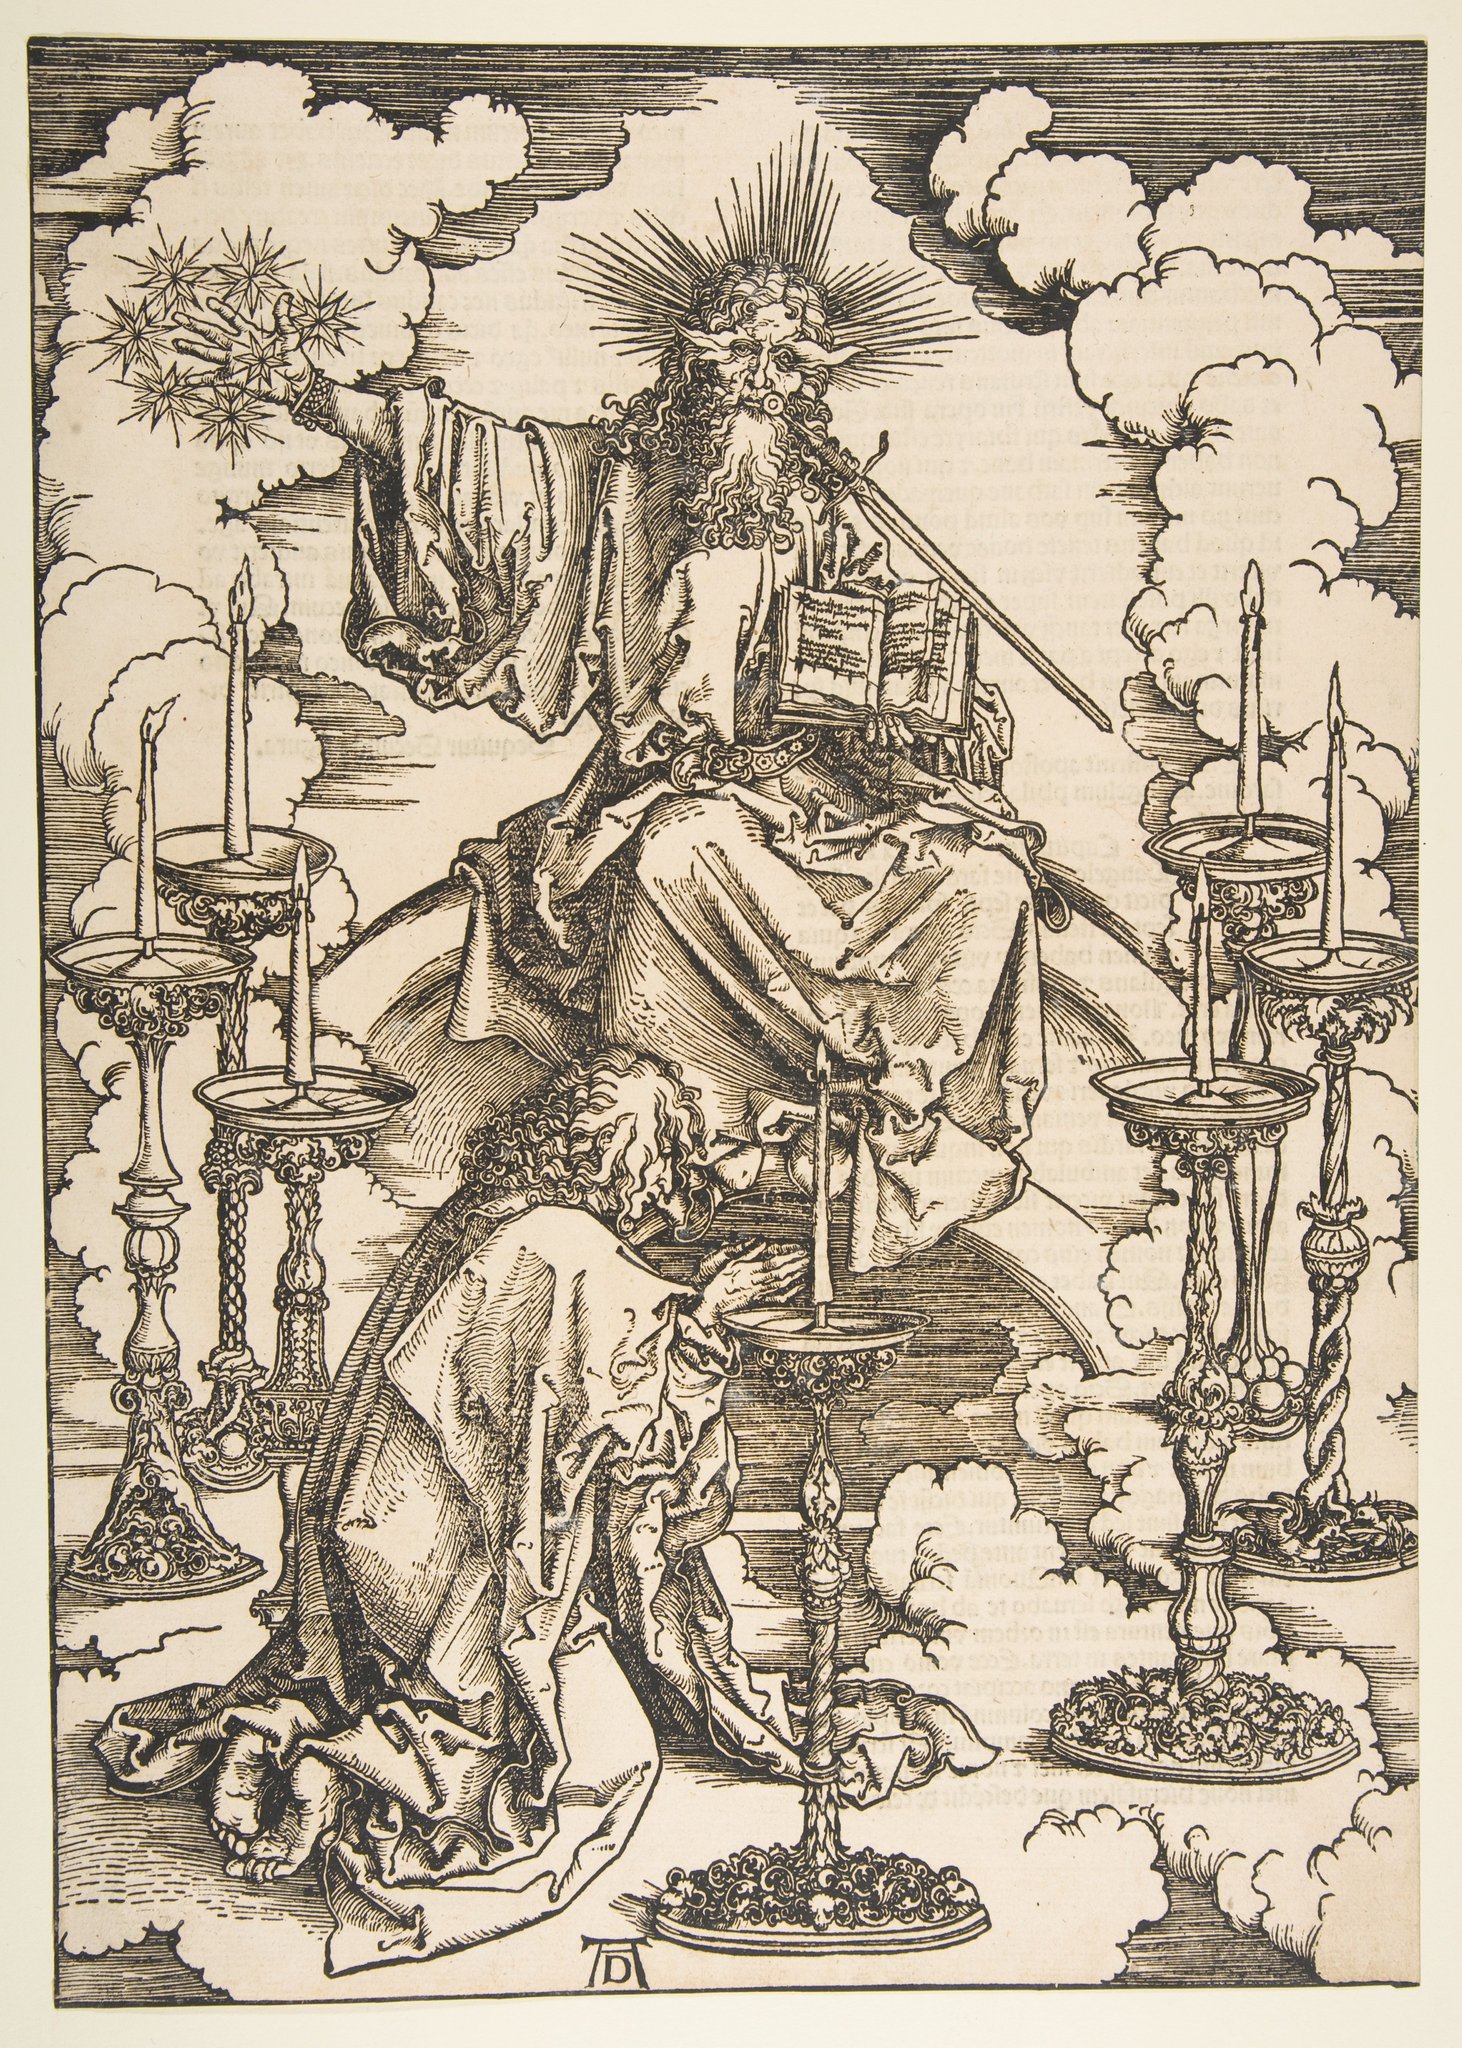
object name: print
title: Saint John Beholding the Seven Golden Candlesticks, from "The Apocalypse"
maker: albrecht dürer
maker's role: artist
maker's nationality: german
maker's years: 1471-1528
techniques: woodcut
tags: books,saint john the evangelist,apocalypse,candlesticks